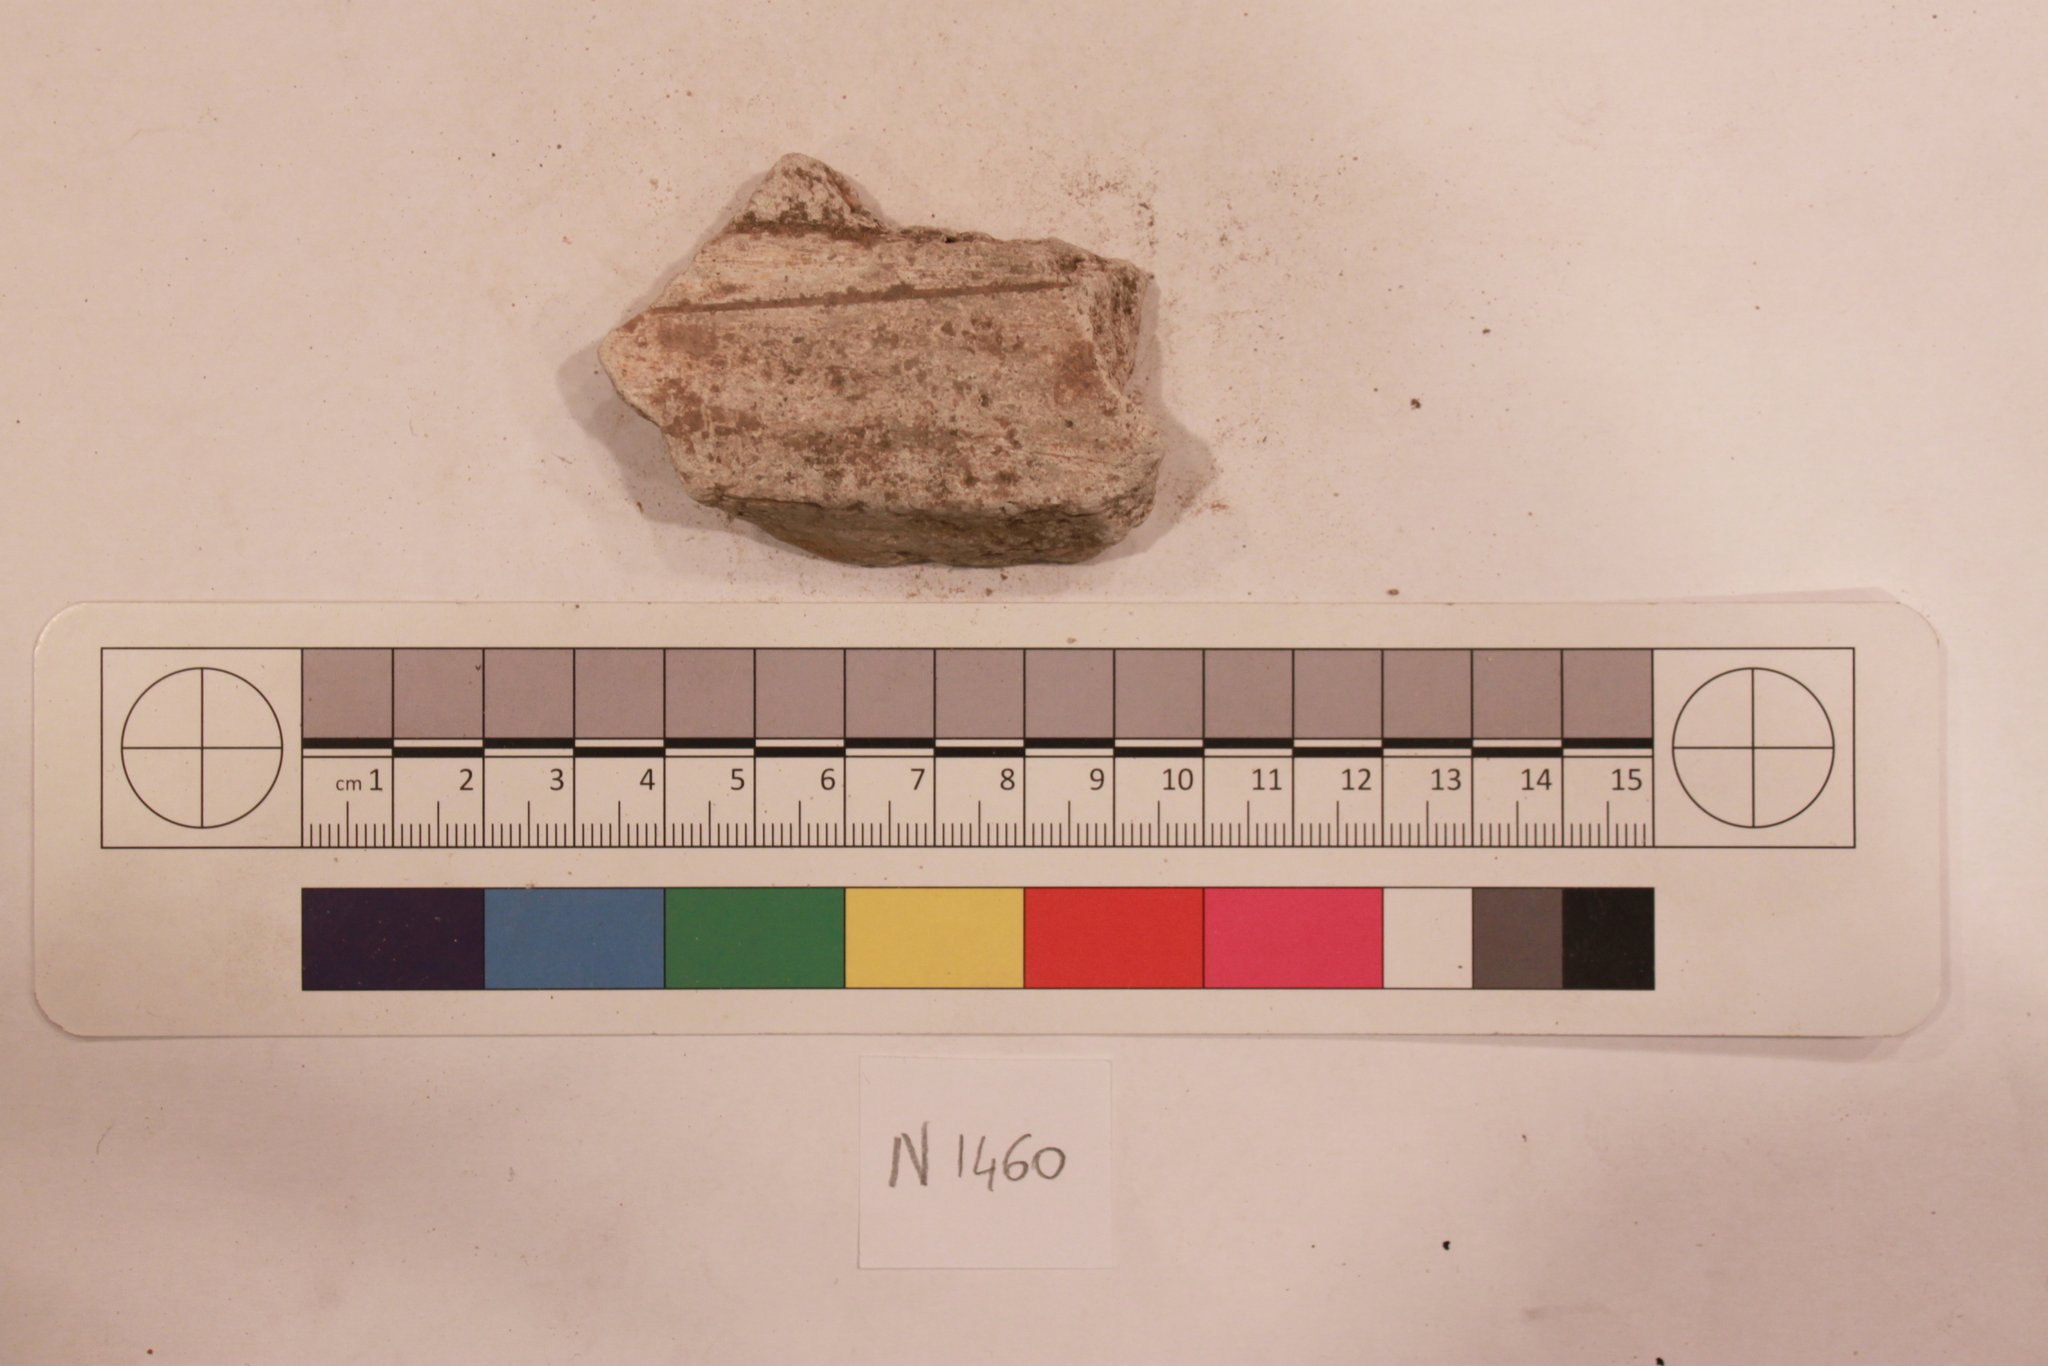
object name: fragment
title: Stucco Fragment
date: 701-1200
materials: plaster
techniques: carving, painting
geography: iran